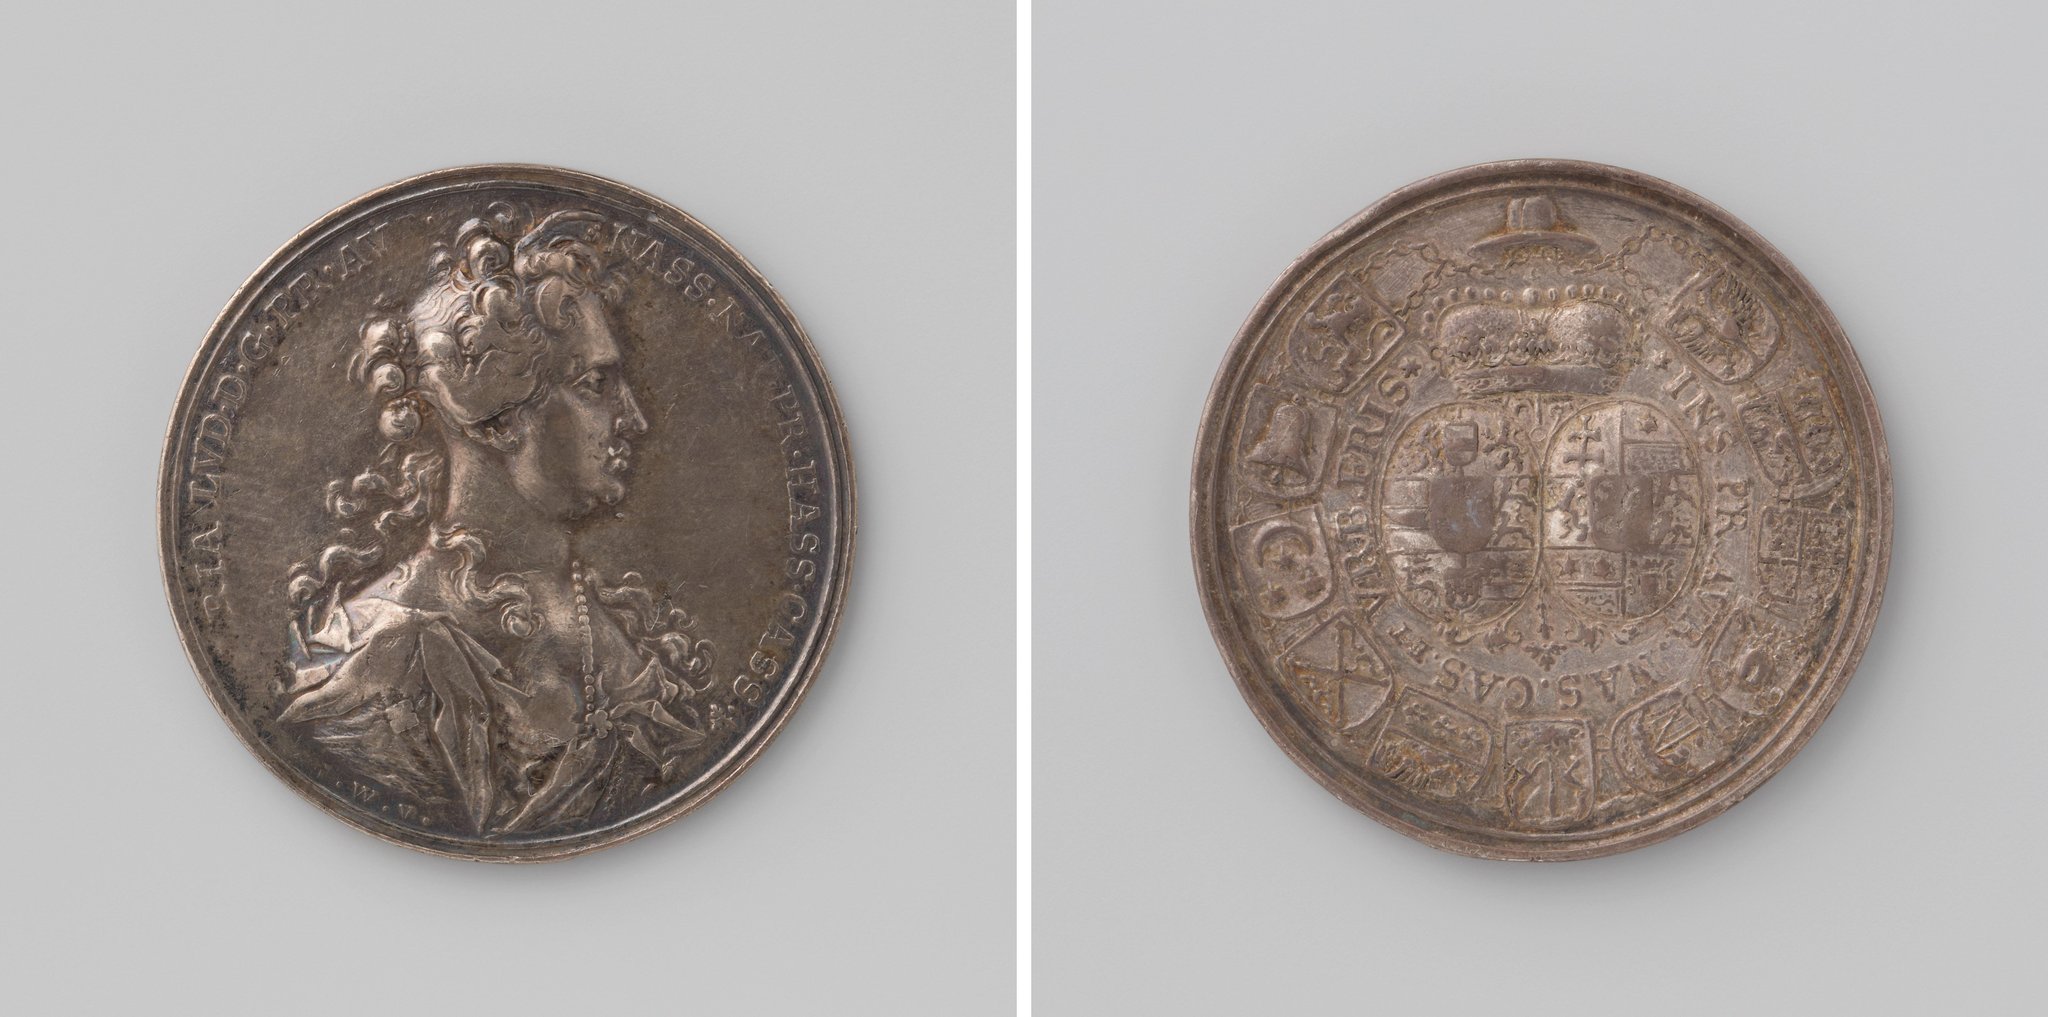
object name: medal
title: Marie Louise, weduwe van Johan Willem Friso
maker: georg wilhelm vestner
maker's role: medailleur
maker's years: 1677-1740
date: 1712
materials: silver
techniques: striking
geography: nuremberg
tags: staten van friesland, kassel, leeuwarden, maria louisa van hessen-kassel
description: Zilveren penning. Voorzijde: borststuk vrouw binnen omschrift. Keerzijde: twee wapenschilden onder kroon en vrijheidshoed binnen omschrift en rand van wapenschilden